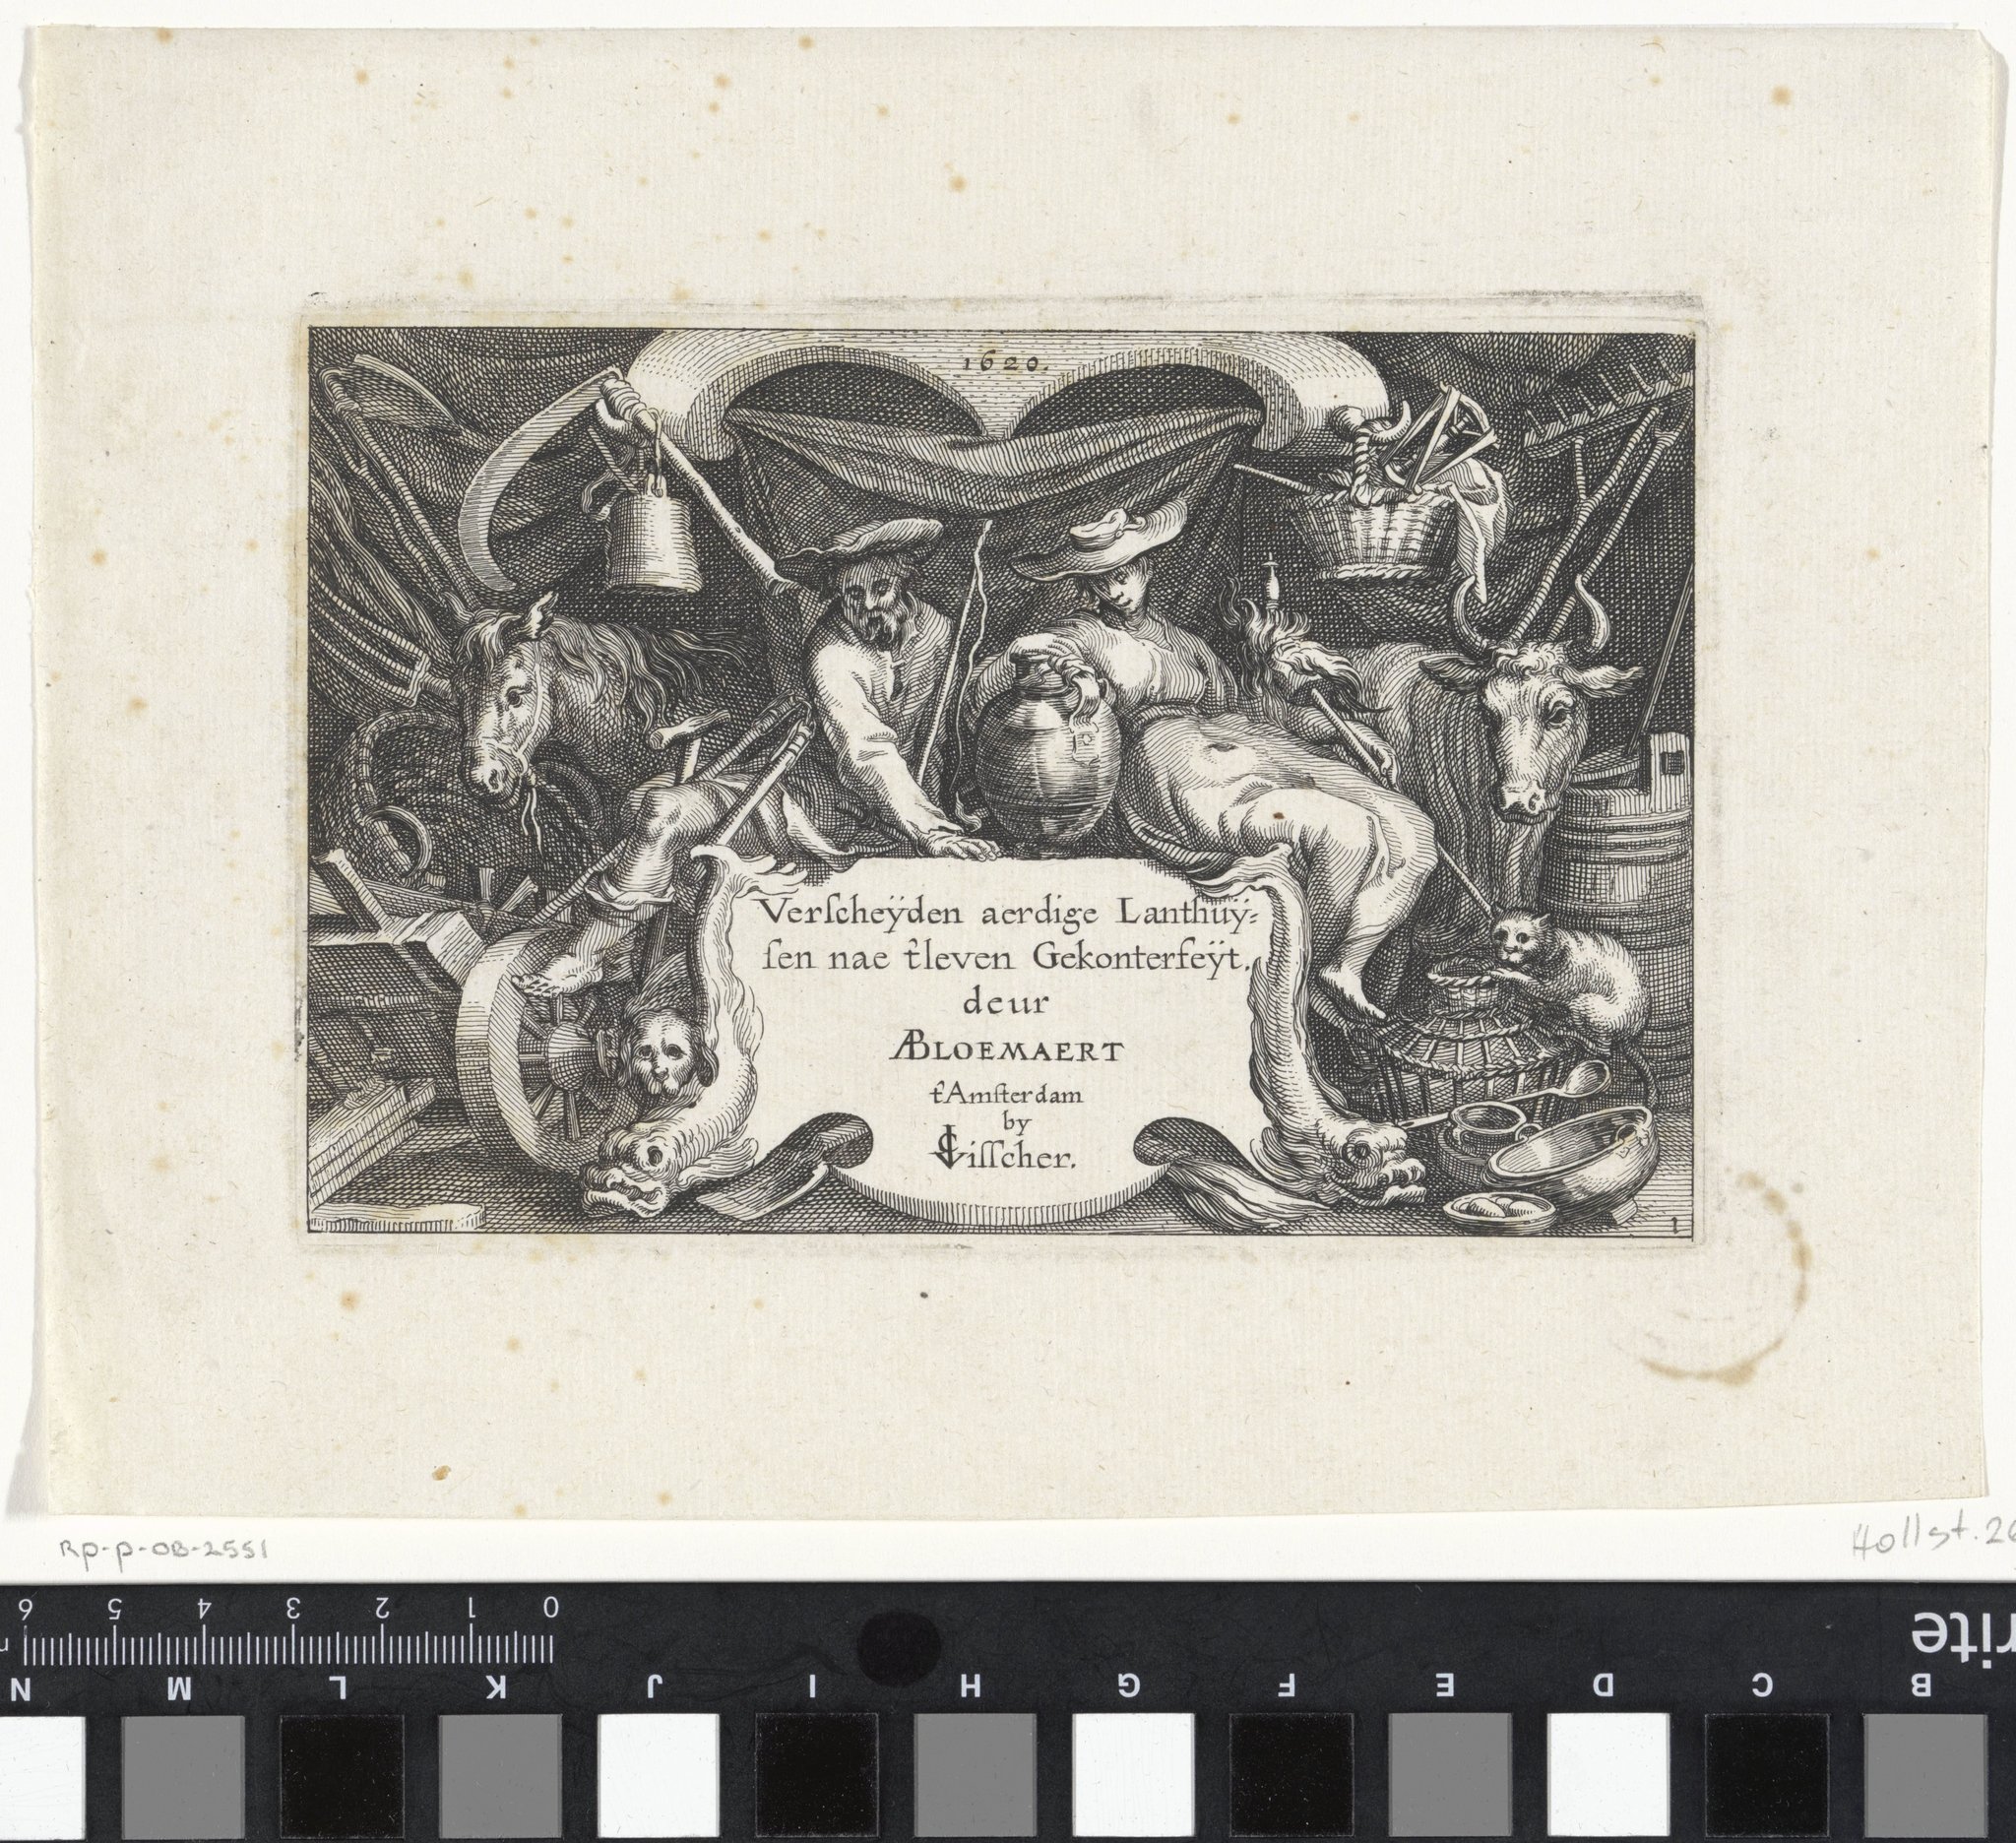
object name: titelprent, frontispice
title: Verscheyden aerdige Lanthey = / sen nae t'leven Gekonterfeyt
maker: claes jansz. visscher (ii)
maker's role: draughtsman, print maker, publisher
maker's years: 1586-1652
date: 1620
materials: paper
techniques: etching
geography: amsterdam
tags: cow, farmers, agricultural implements, horse, agriculture, cattle-breeding, horticulture, flowerculture, etc.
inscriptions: collector's mark: Lugt 240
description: Titelprent voor een reeks van 26 landschappen naar Abraham Bloemaert. Het cartouche met de titel is omringd door landbouwwerktuigen, een herder en een herderin en een paard en een koe.